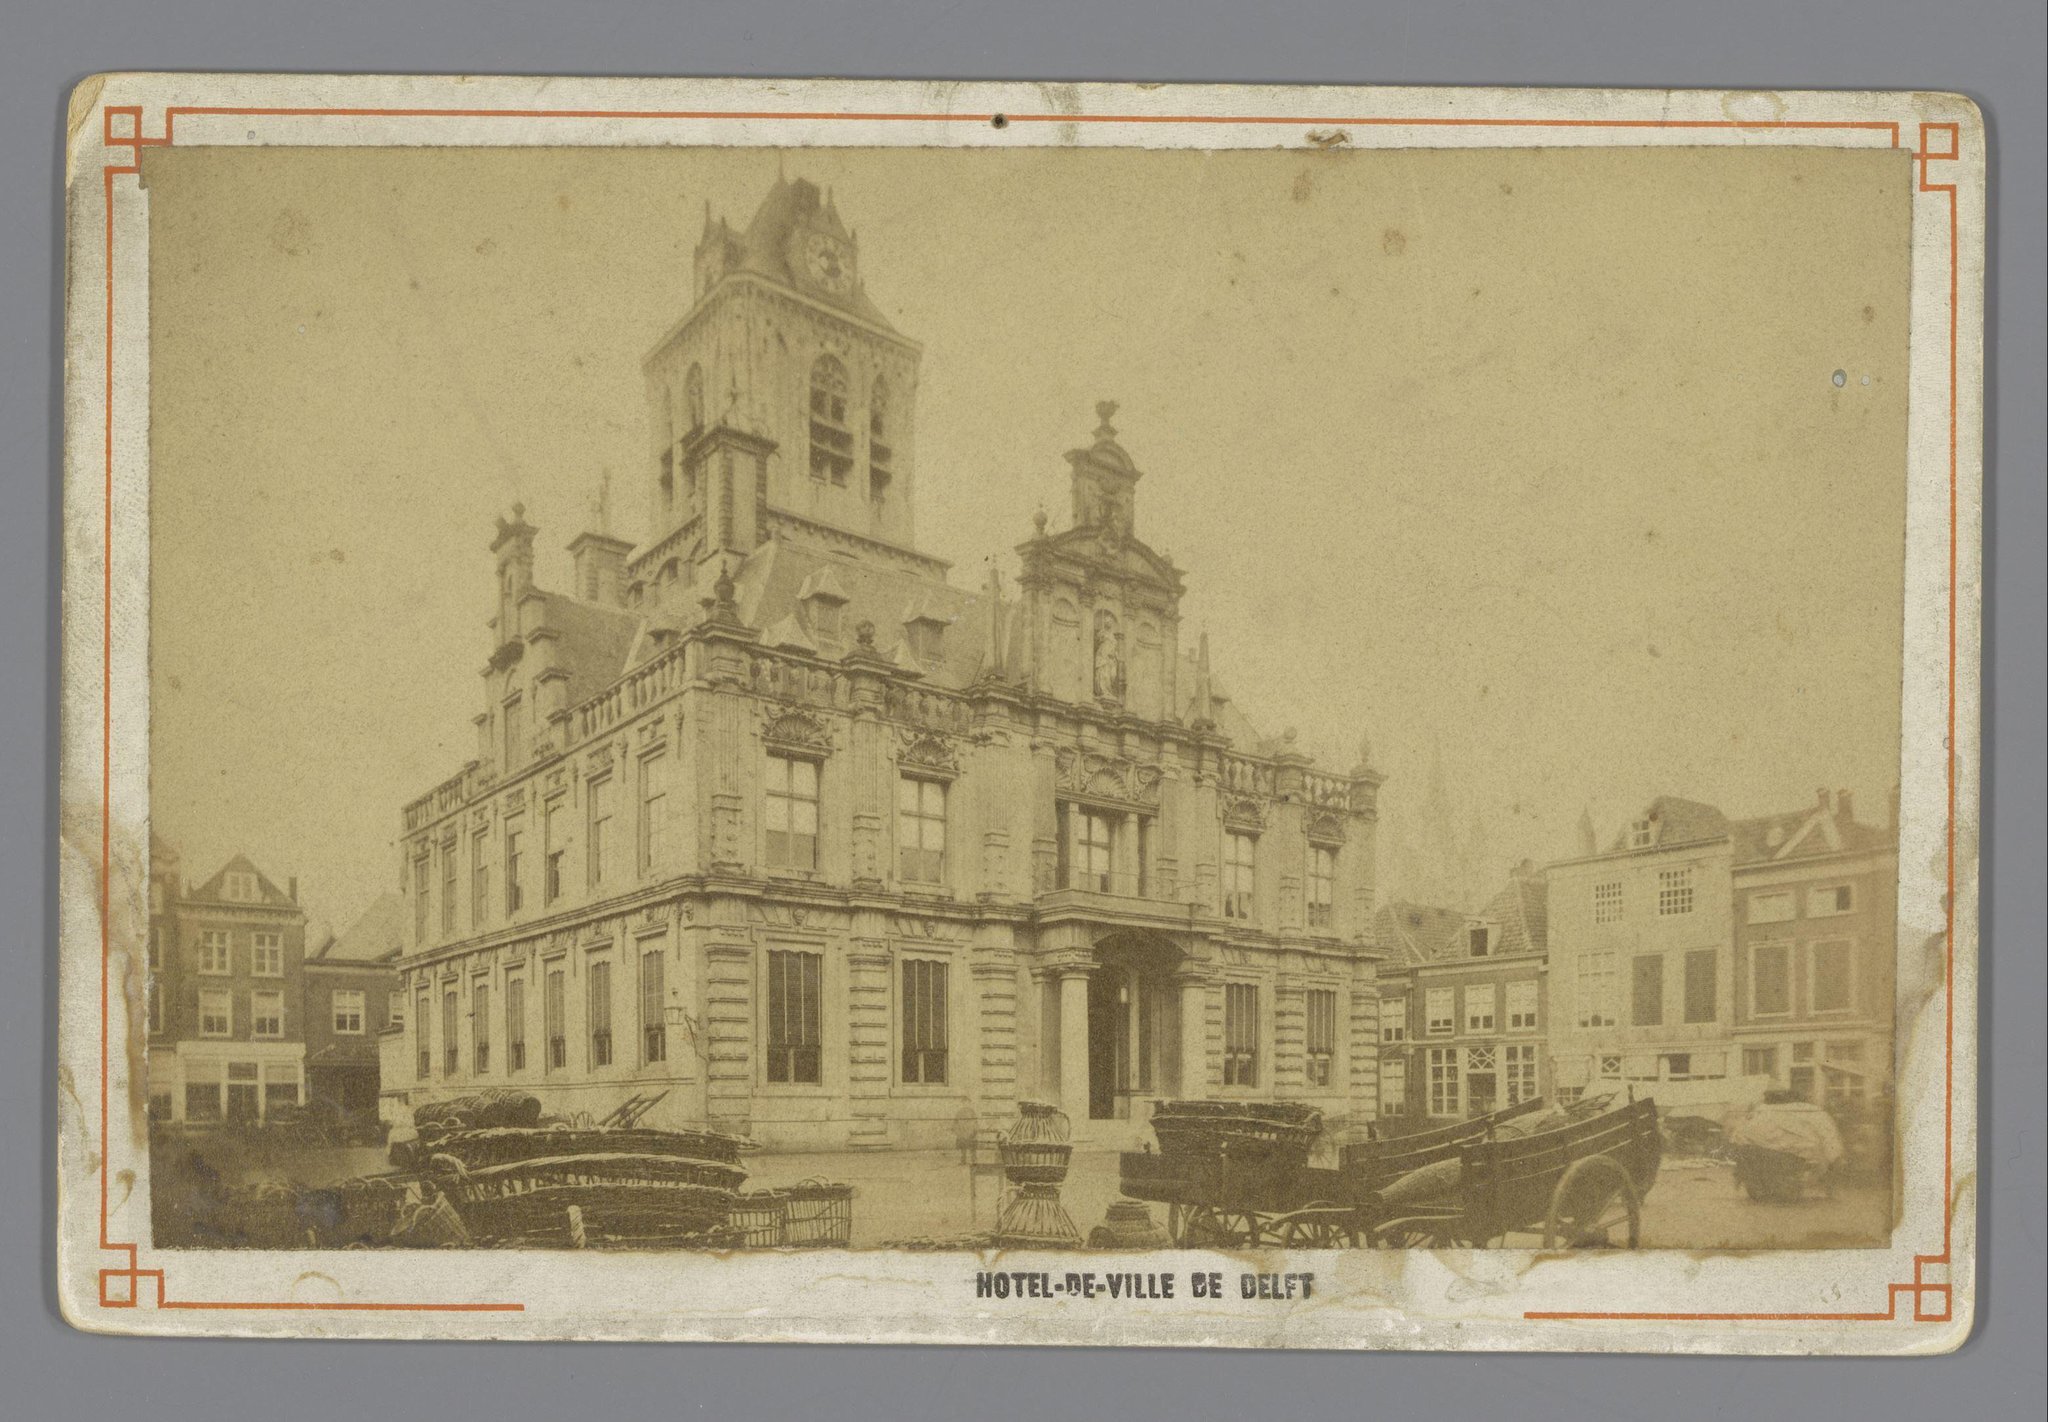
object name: photograph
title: Gezicht op het stadhuis te Delft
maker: Anonymous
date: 1860-1890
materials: cardboard, photographic support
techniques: albumen print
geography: delft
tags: townhall